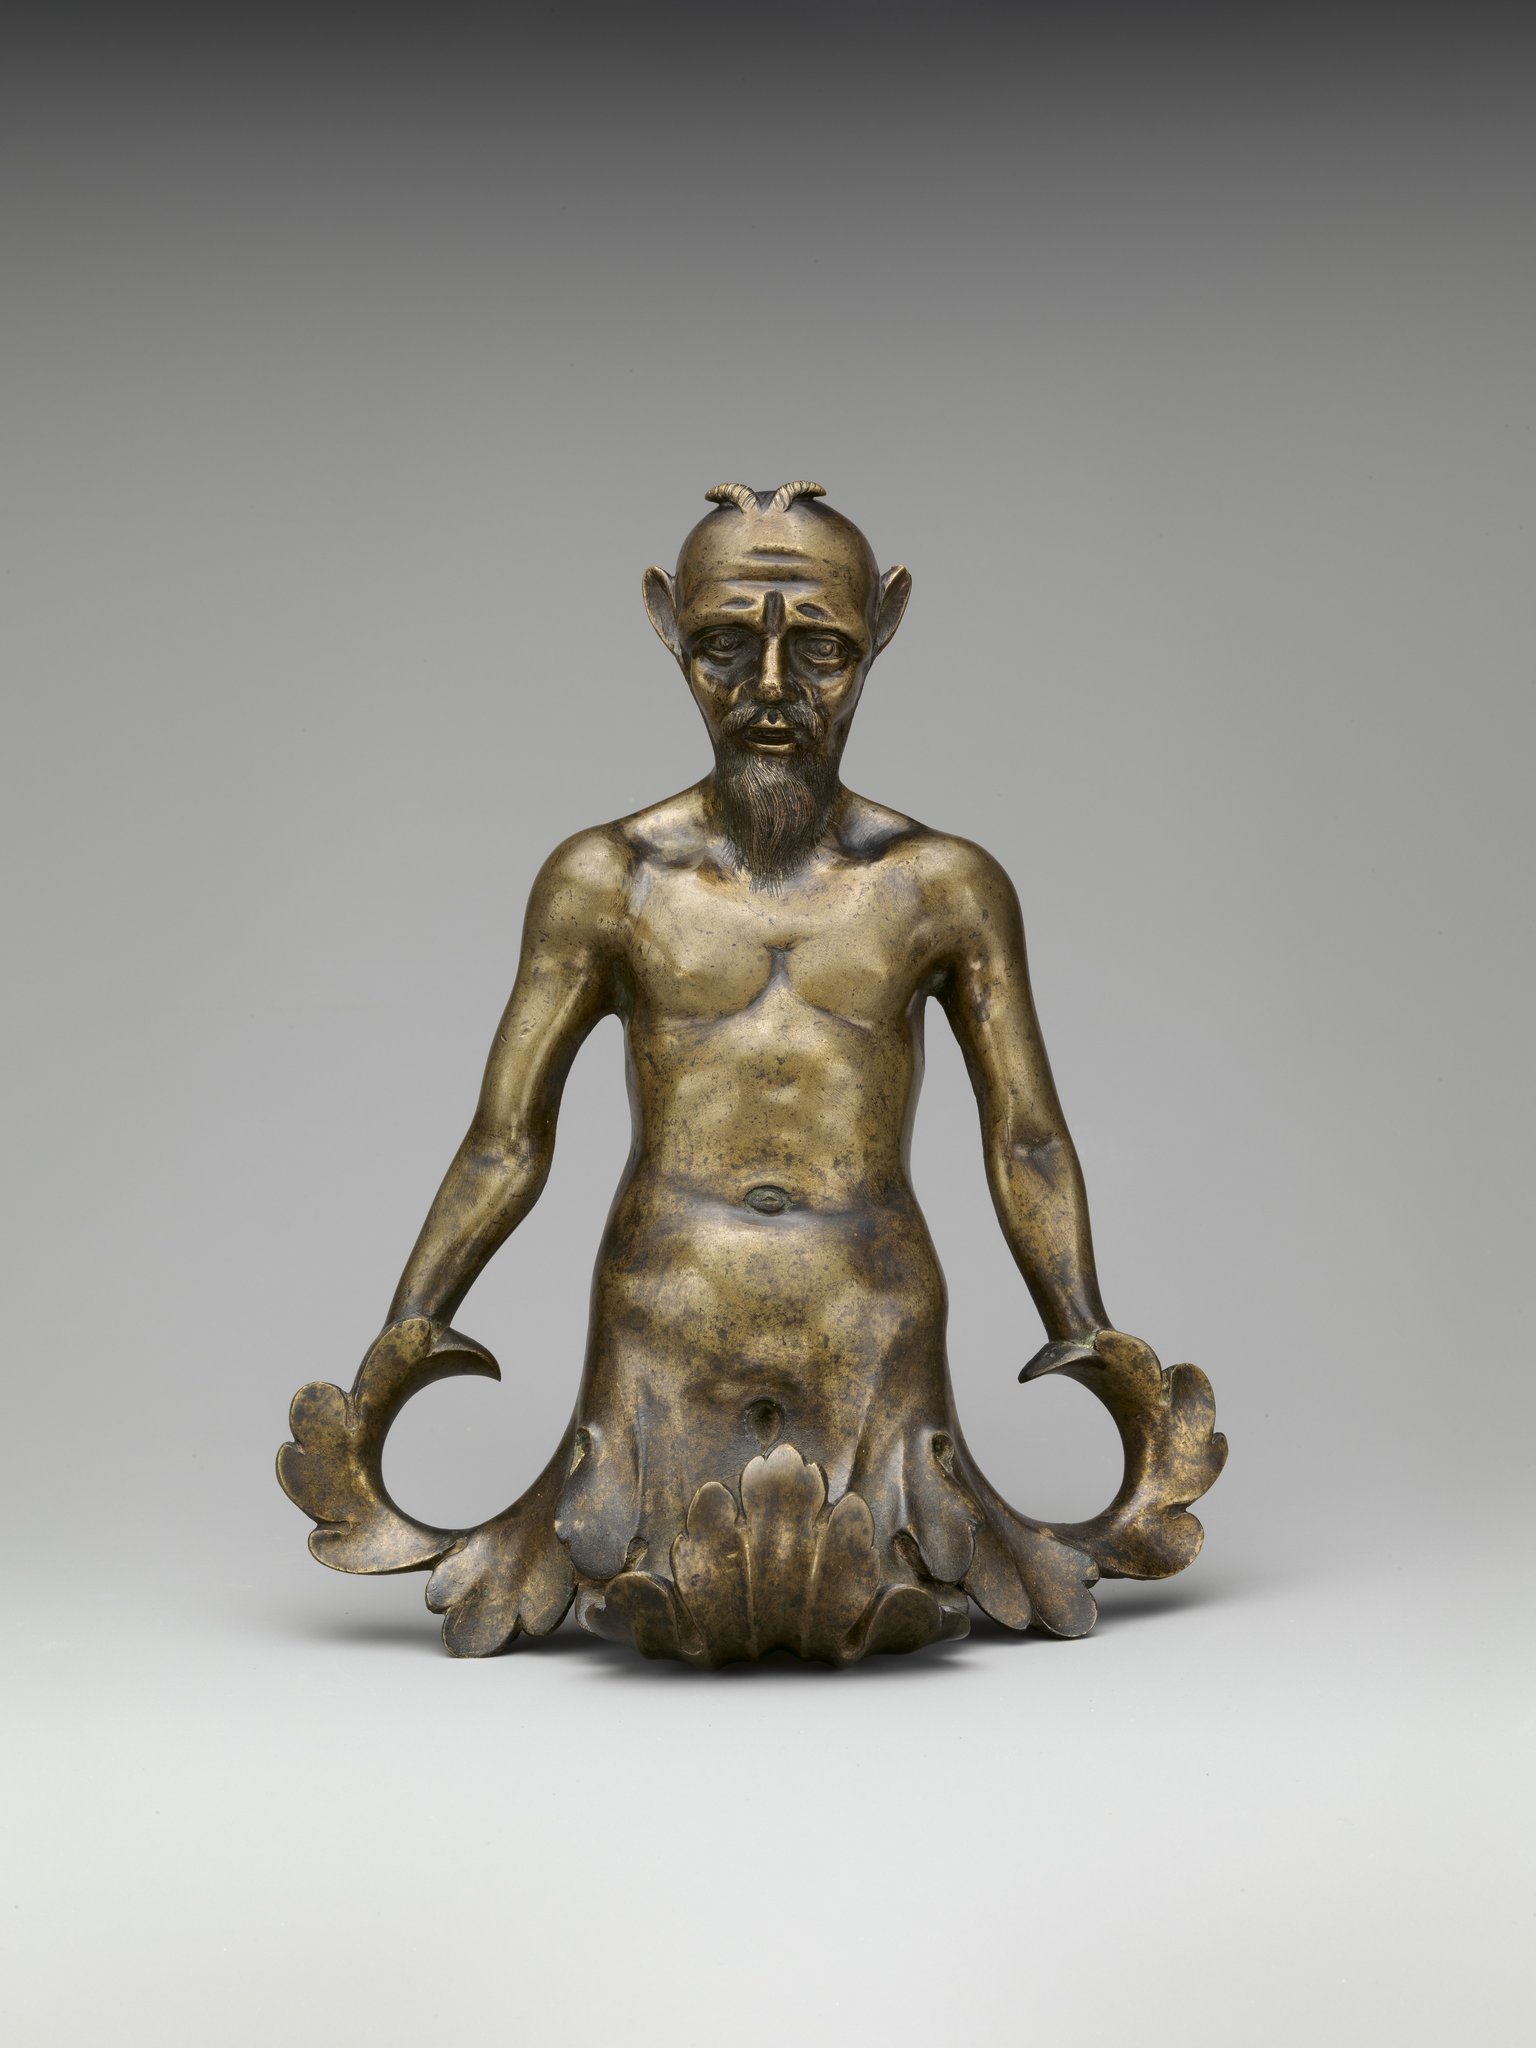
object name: door knocker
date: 1560-1570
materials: brass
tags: men